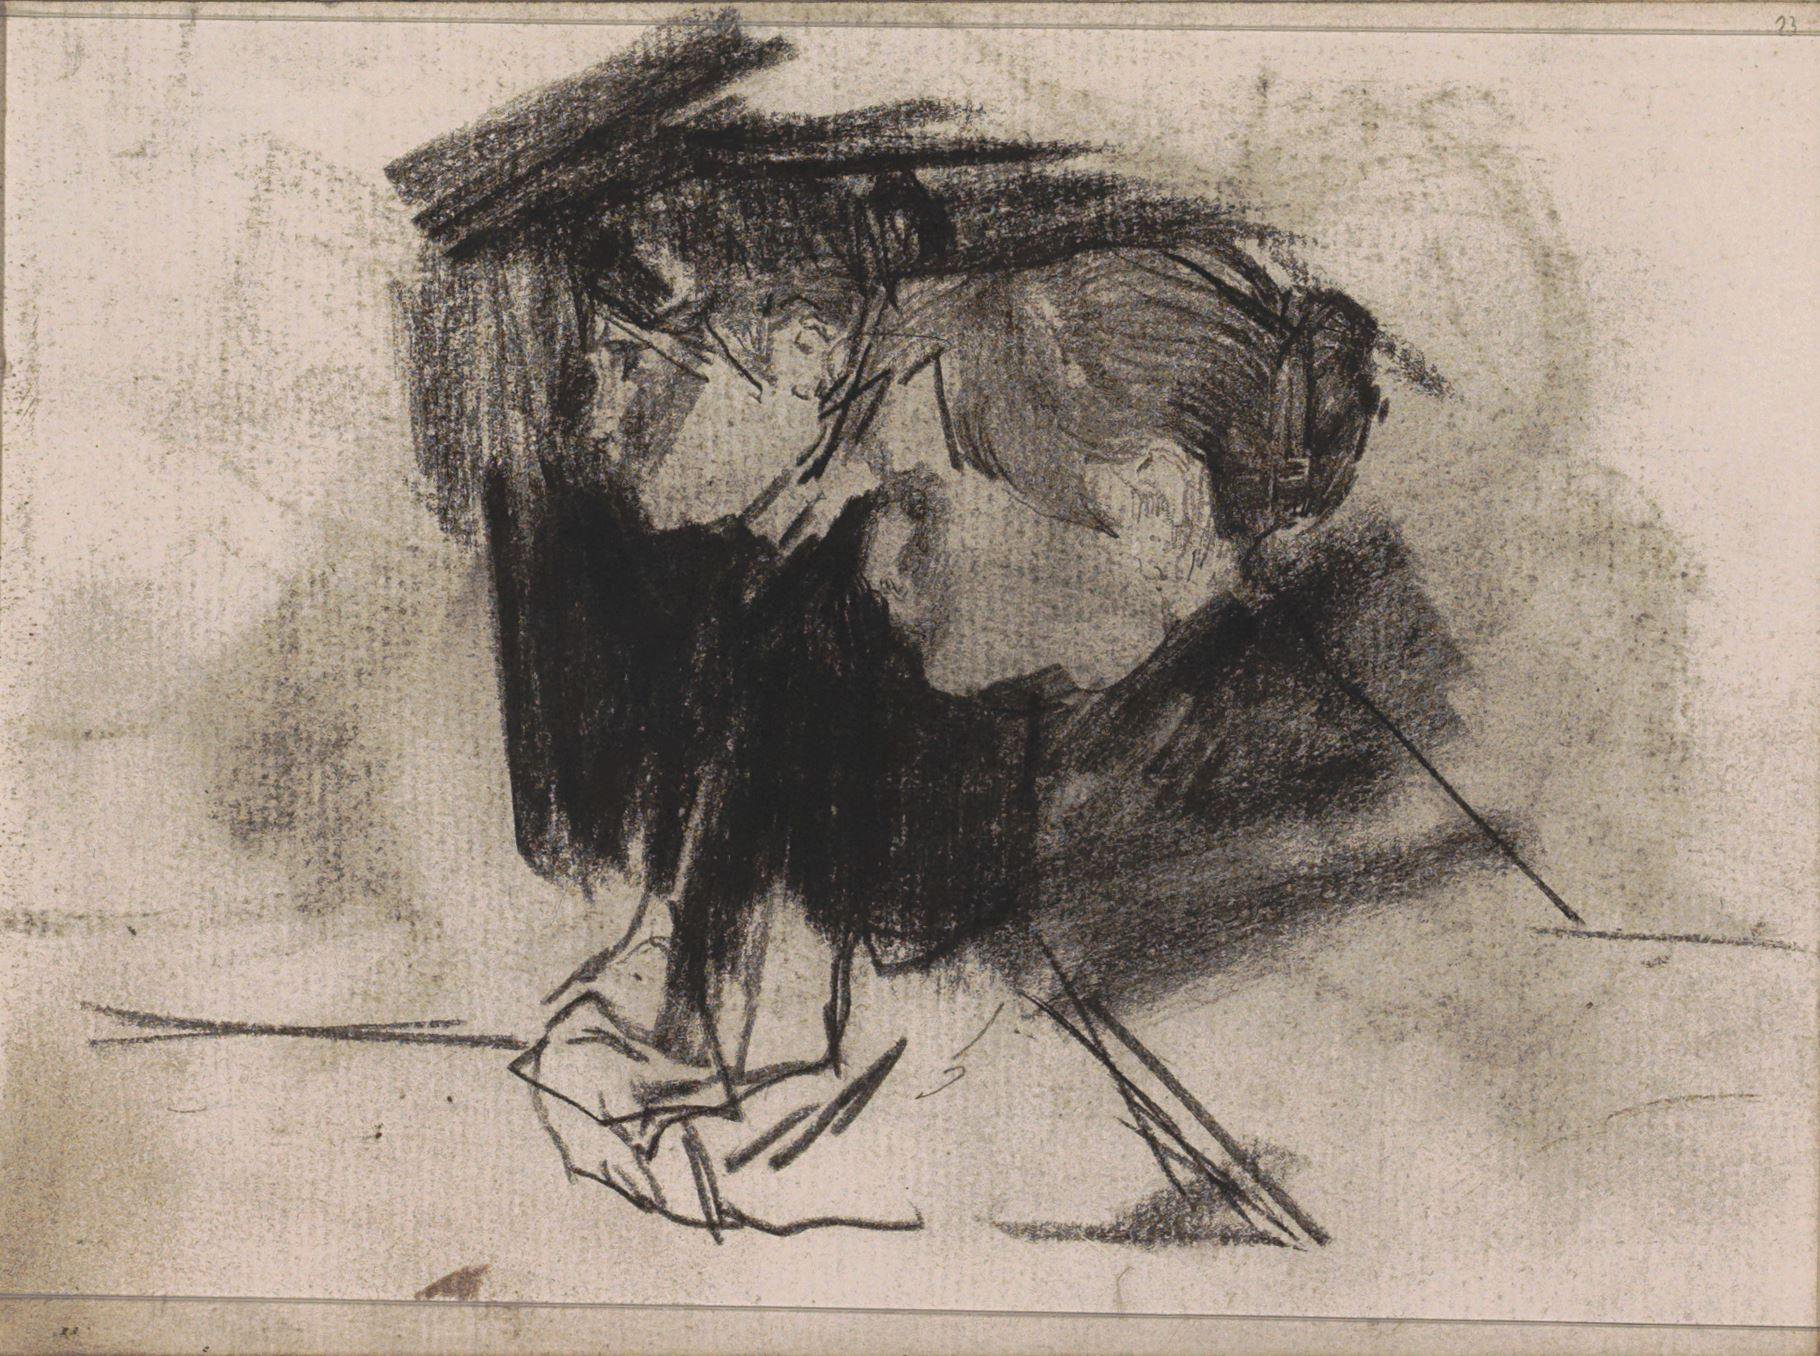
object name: sketchbook leaf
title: Twee gearmde vrouwen, in profiel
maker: isaac israels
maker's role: draughtsman, painter, print maker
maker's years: 1865-1934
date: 1886-1903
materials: chalk, paper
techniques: stumping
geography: amsterdam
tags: arm in arm (friends), adult woman (+ two persons), working class, labourers - aa - women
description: Mogelijk waspitten. Pagina 23 uit schetsboek XLVII met 52 pagina's.